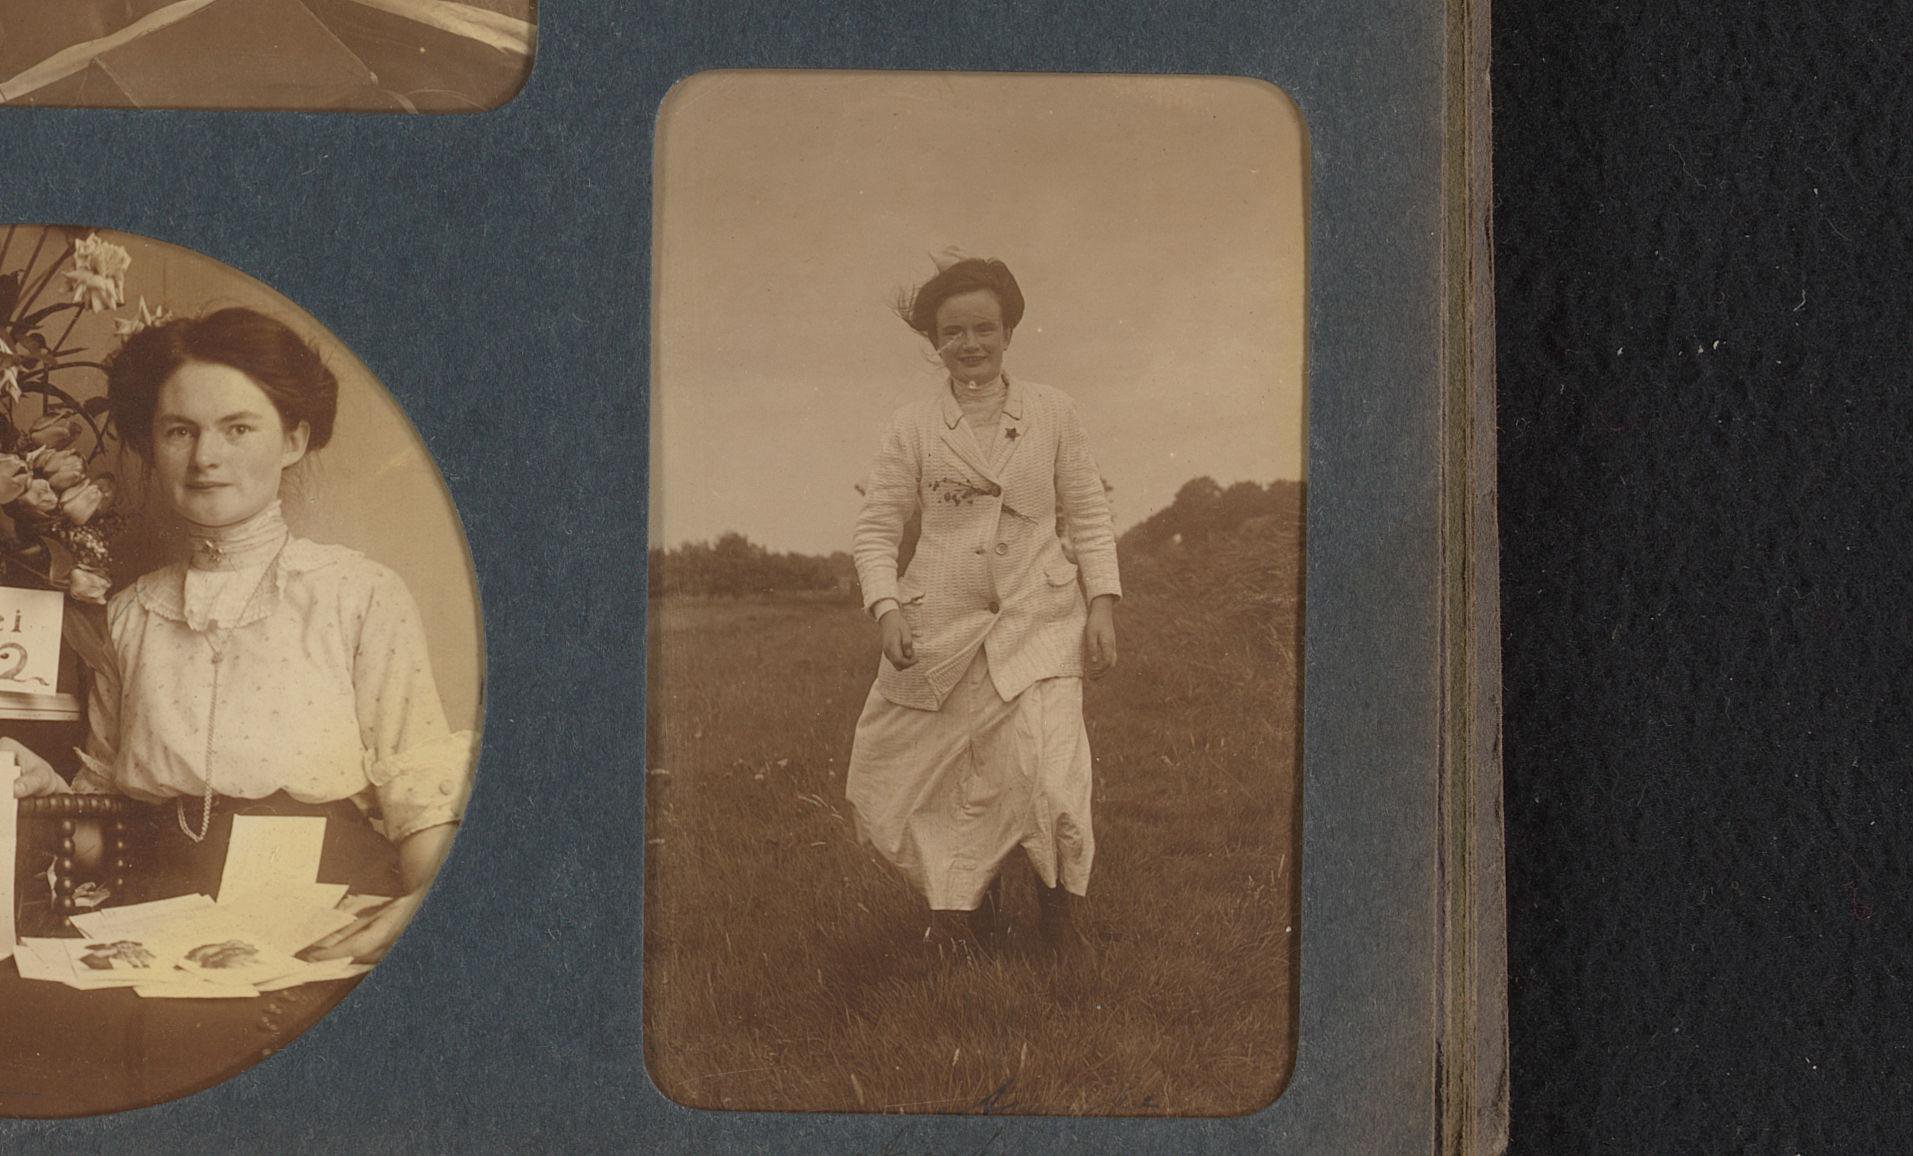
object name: album leaf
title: Portret van Anneke Merkus in het gras, vermoedelijk in Gelderland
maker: Anonymous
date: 1908-1912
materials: paper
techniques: gelatin silver print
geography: gelderland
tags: adolescent, young woman, maiden, historical persons, gelderland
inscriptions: inscription: ‘Anneke Merkus. Aug. 1912.’